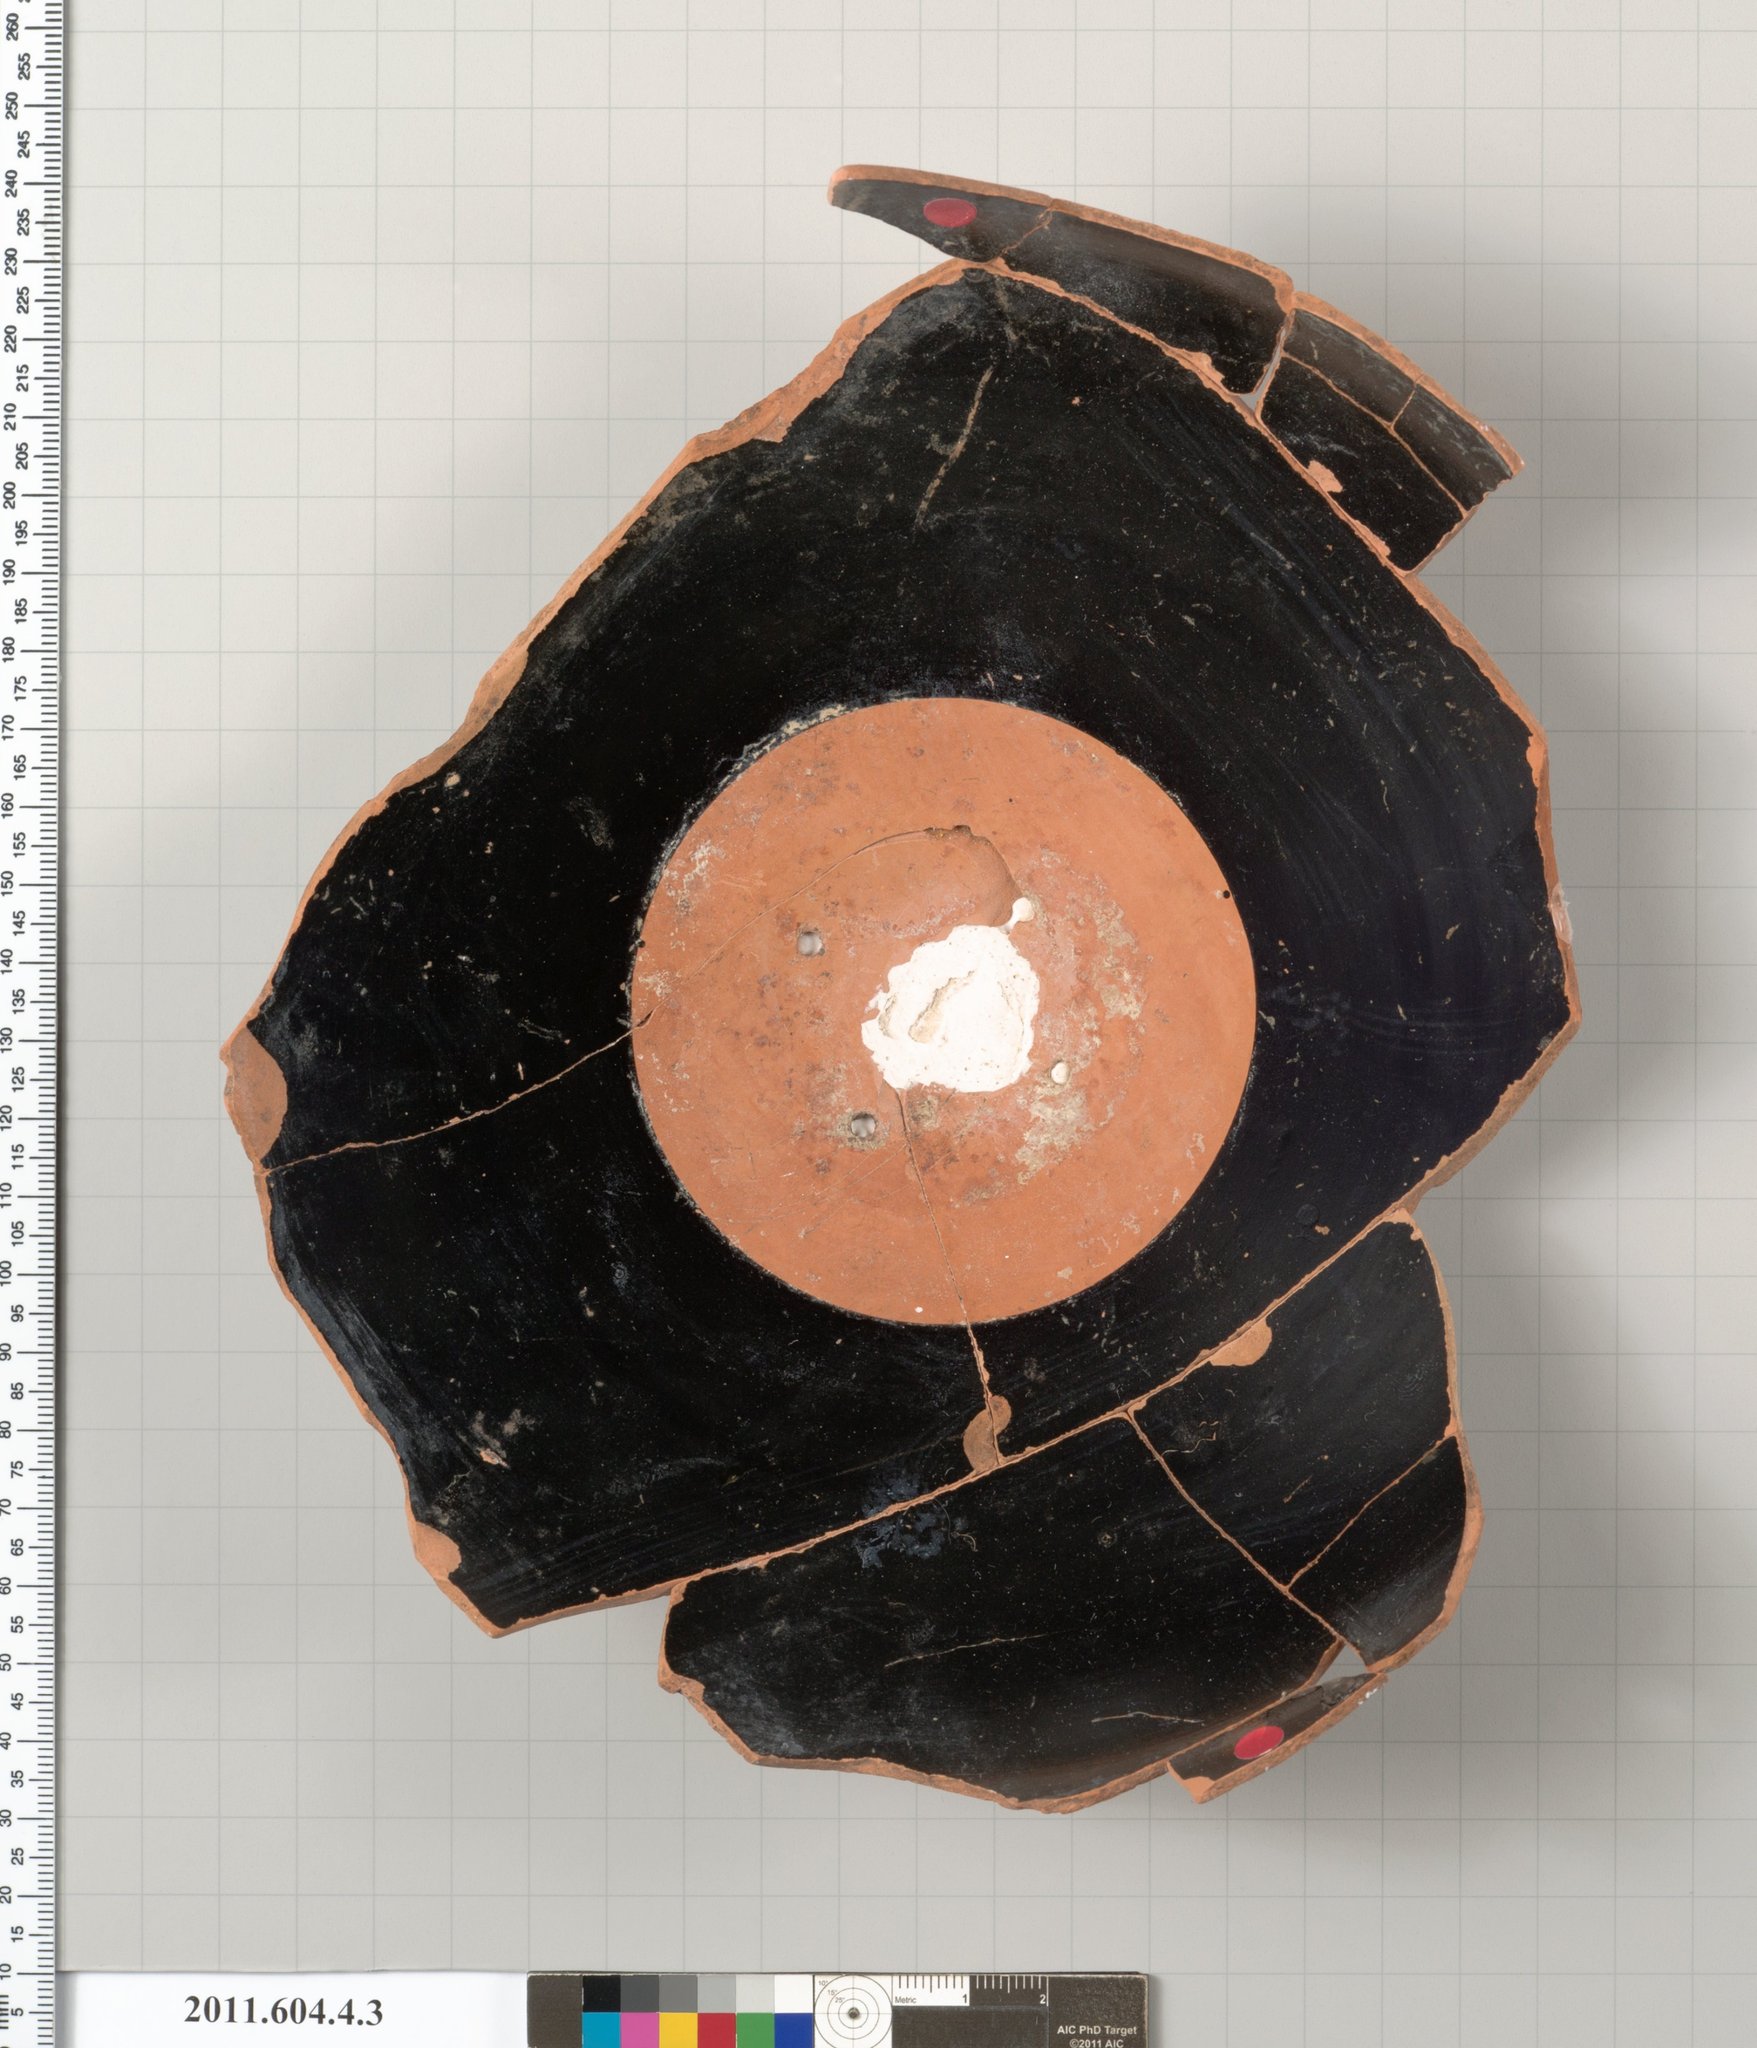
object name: kylix fragment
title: Terracotta fragment of a kylix: band-cup (drinking cup)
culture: greek, attic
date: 550-526 BCE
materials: terracotta